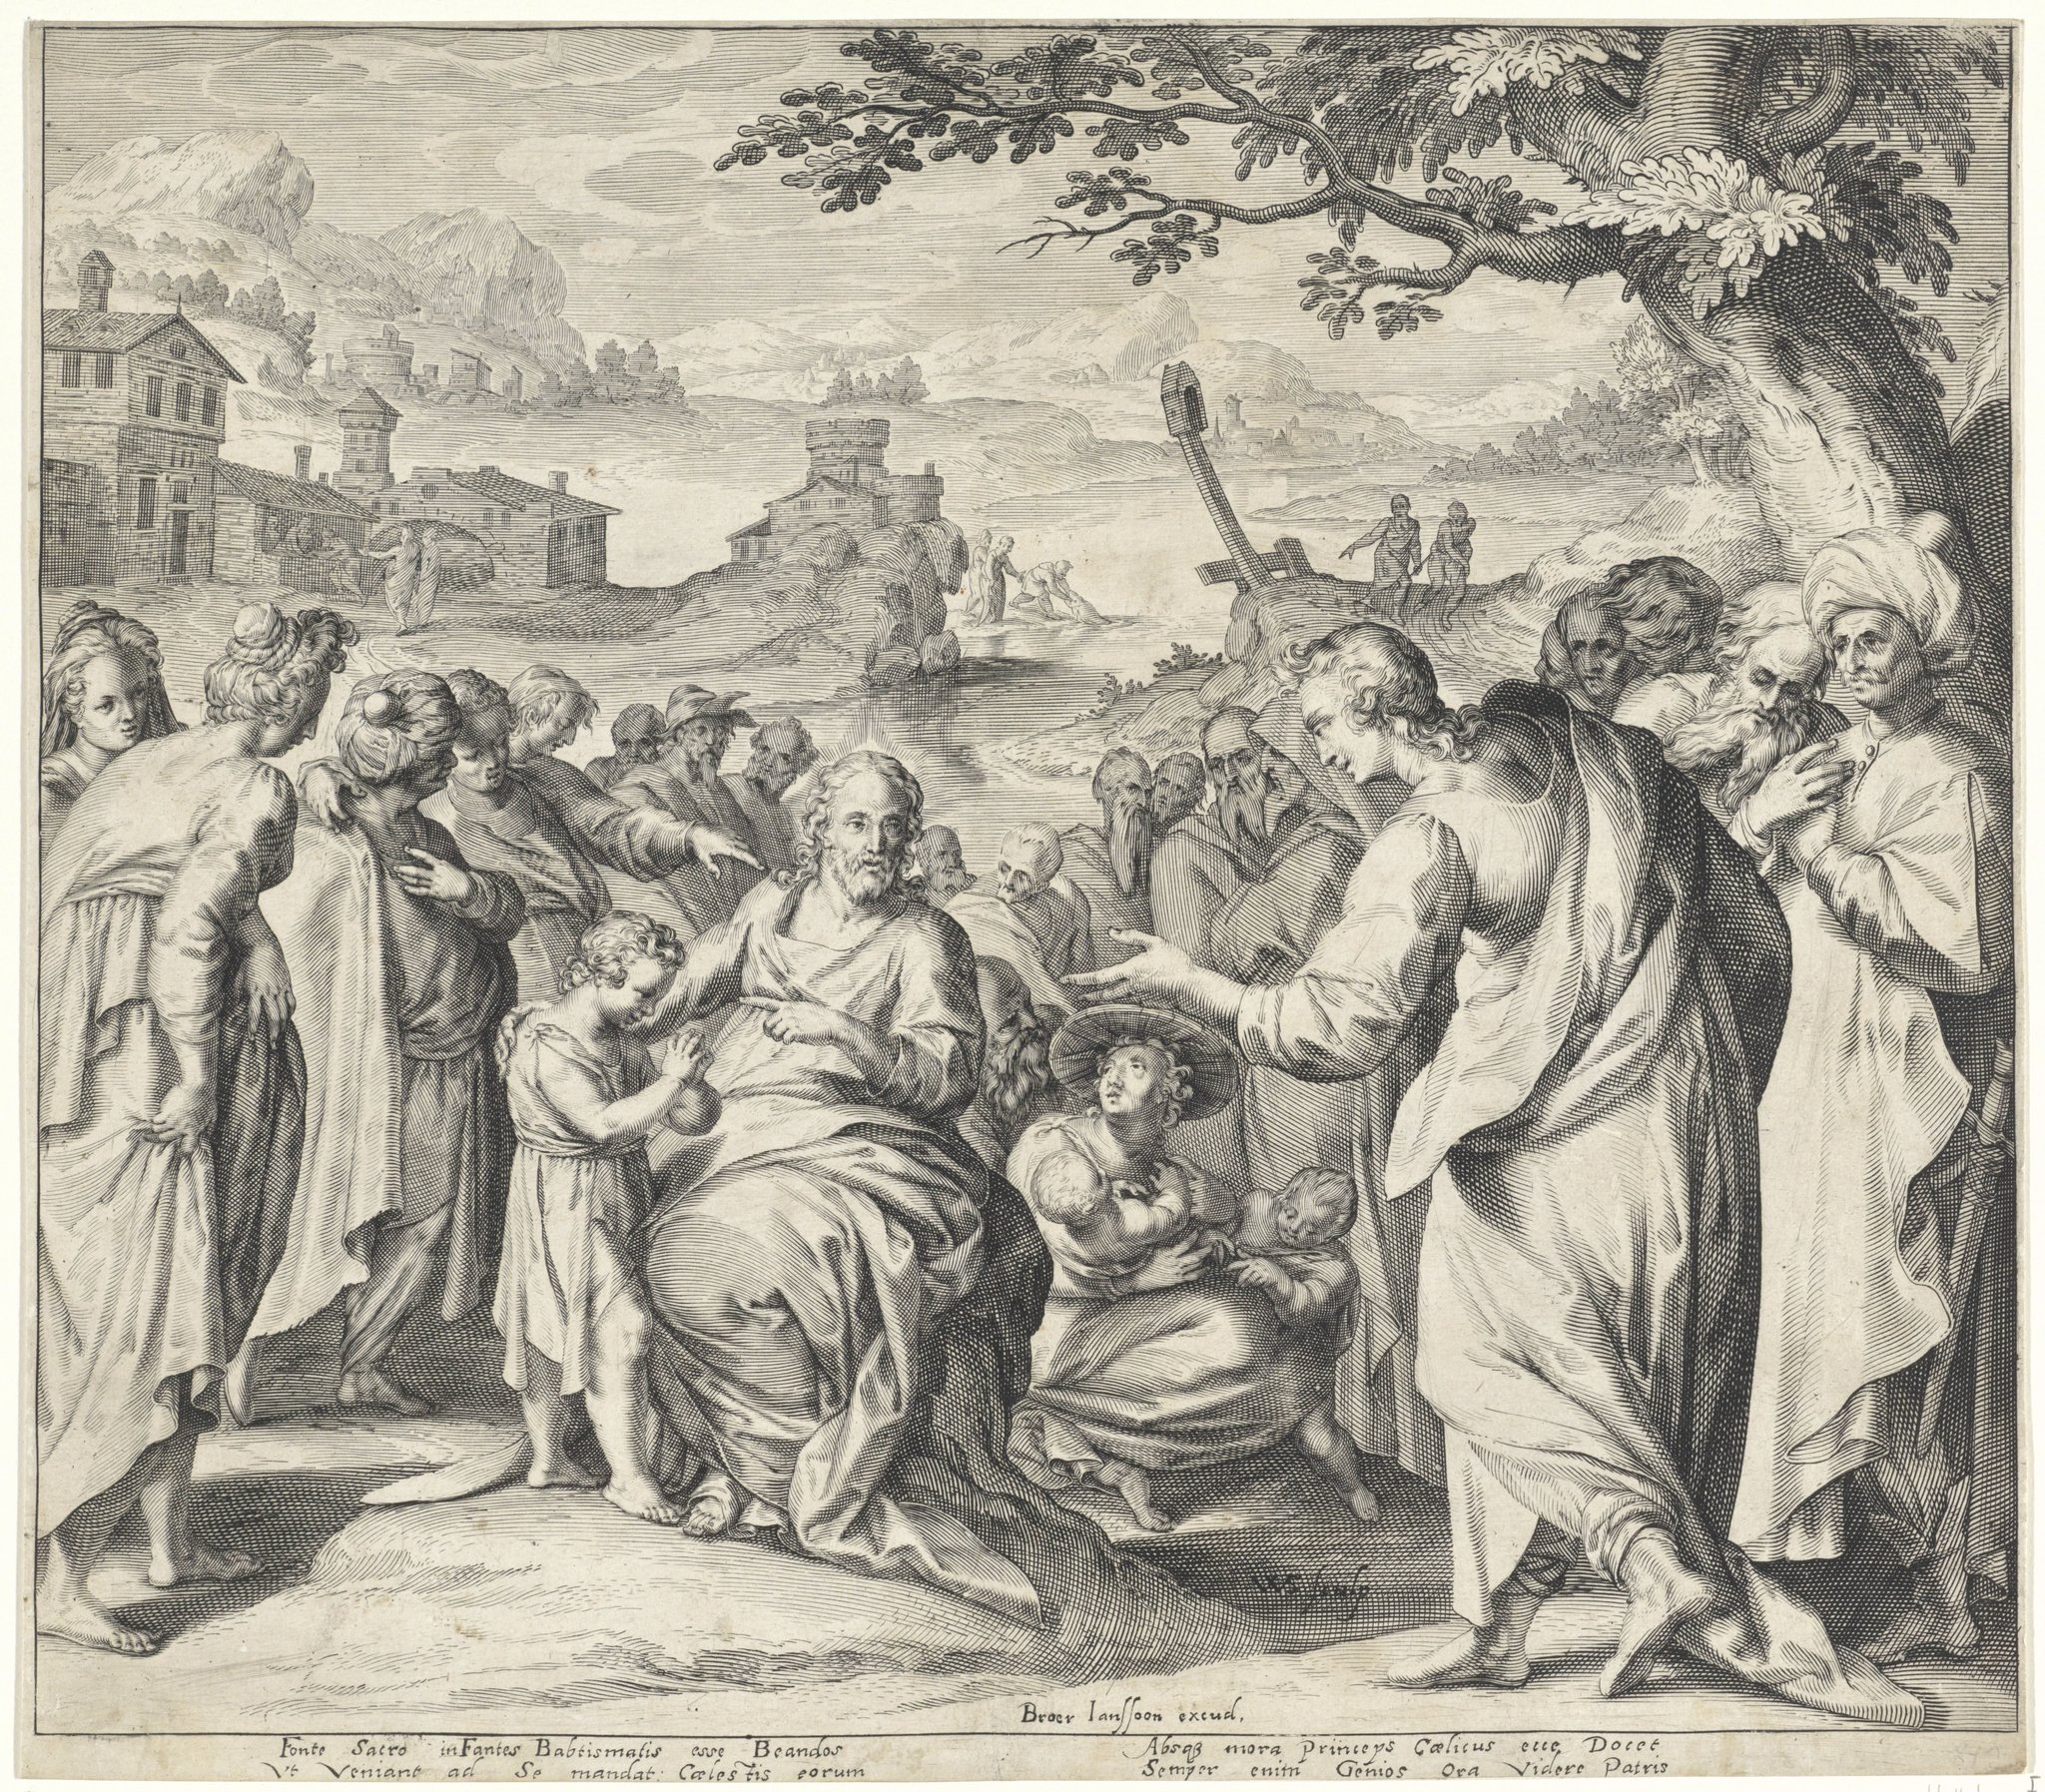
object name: print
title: Christus zegent de kinderen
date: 1603-1652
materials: paper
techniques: engraving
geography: amsterdam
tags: christ blessing children brought by their mothers, usually with some disciples disapprovingly looking on (matthew 19:13-15; mark 10:13-16; luke 18:15-17)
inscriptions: collector's mark: Lugt 2228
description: Christus zit te midden van een groep mensen, onder wie enkelen van zijn leerlingen en een paar moeders. Naast hem zit een moeder met twee kinderen. Hij heeft zijn arm om een jongen met gevouwen handen geslagen en spreekt tot de leerling die voor hem staat. In de verte staan enkele huizen. Onder de voorstelling bevindt zich een vierregelige, Latijnse tekst met een beschrijving van wat Christus in de scène zegt.